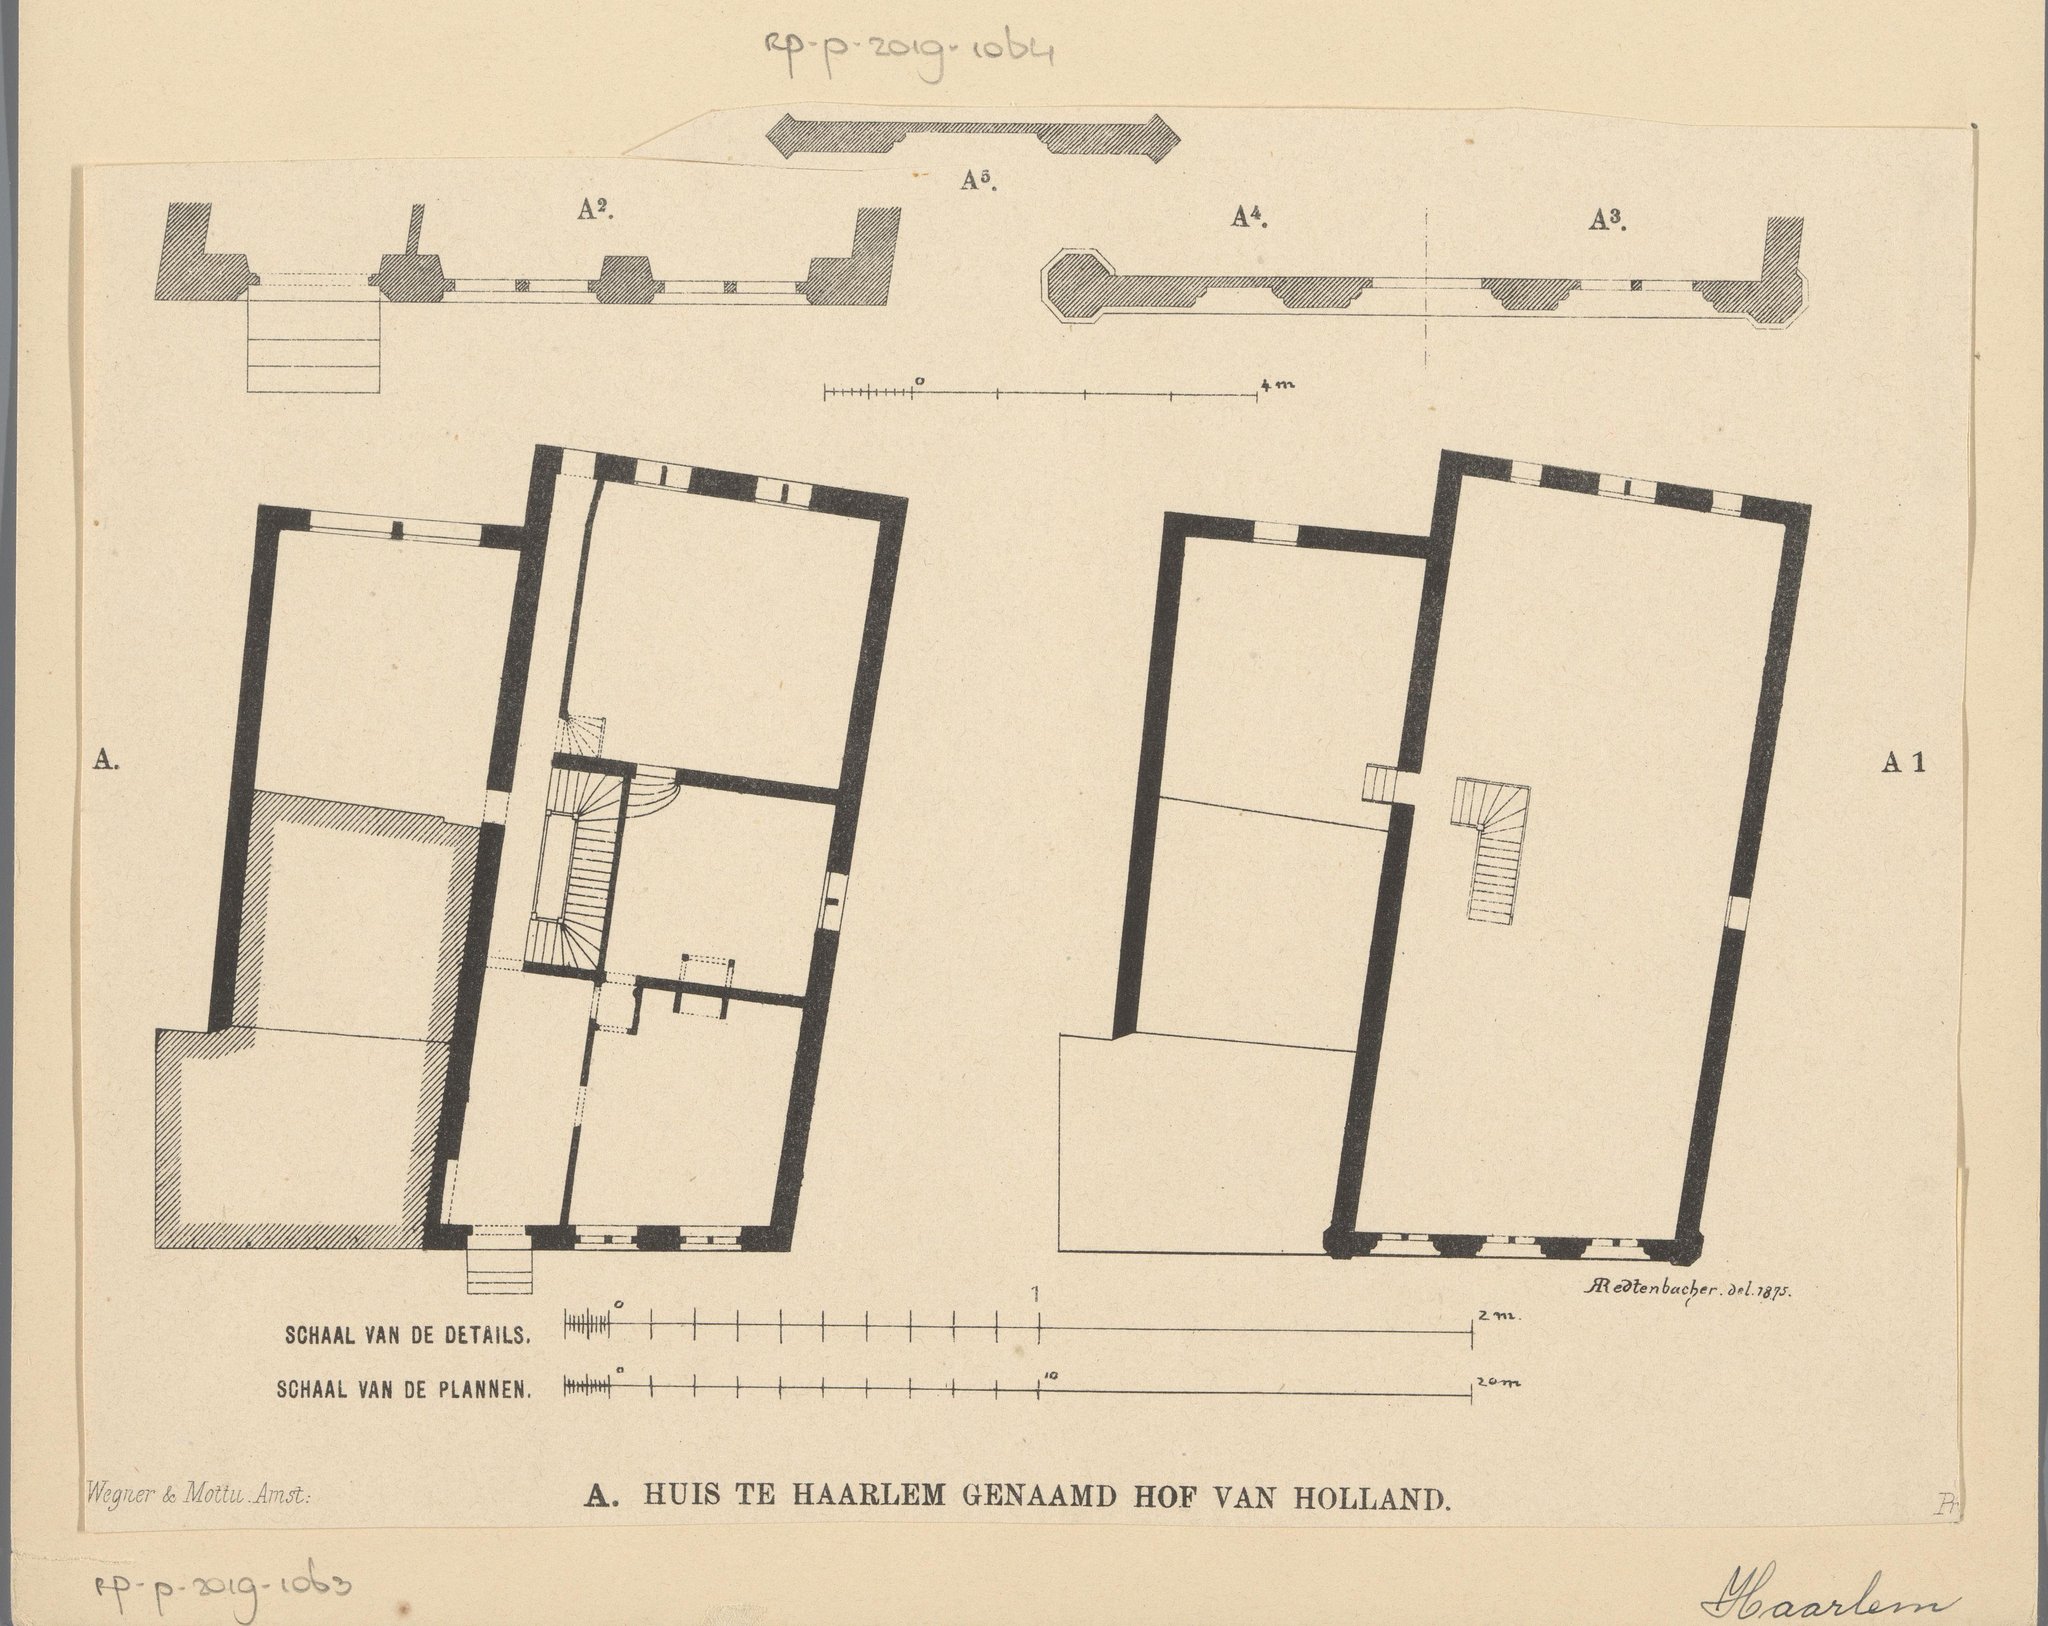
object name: print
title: Grondplannen van het huis Hof van Holland in Haarlem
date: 1862-1917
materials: paper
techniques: lithograph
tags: front façade, haarlem